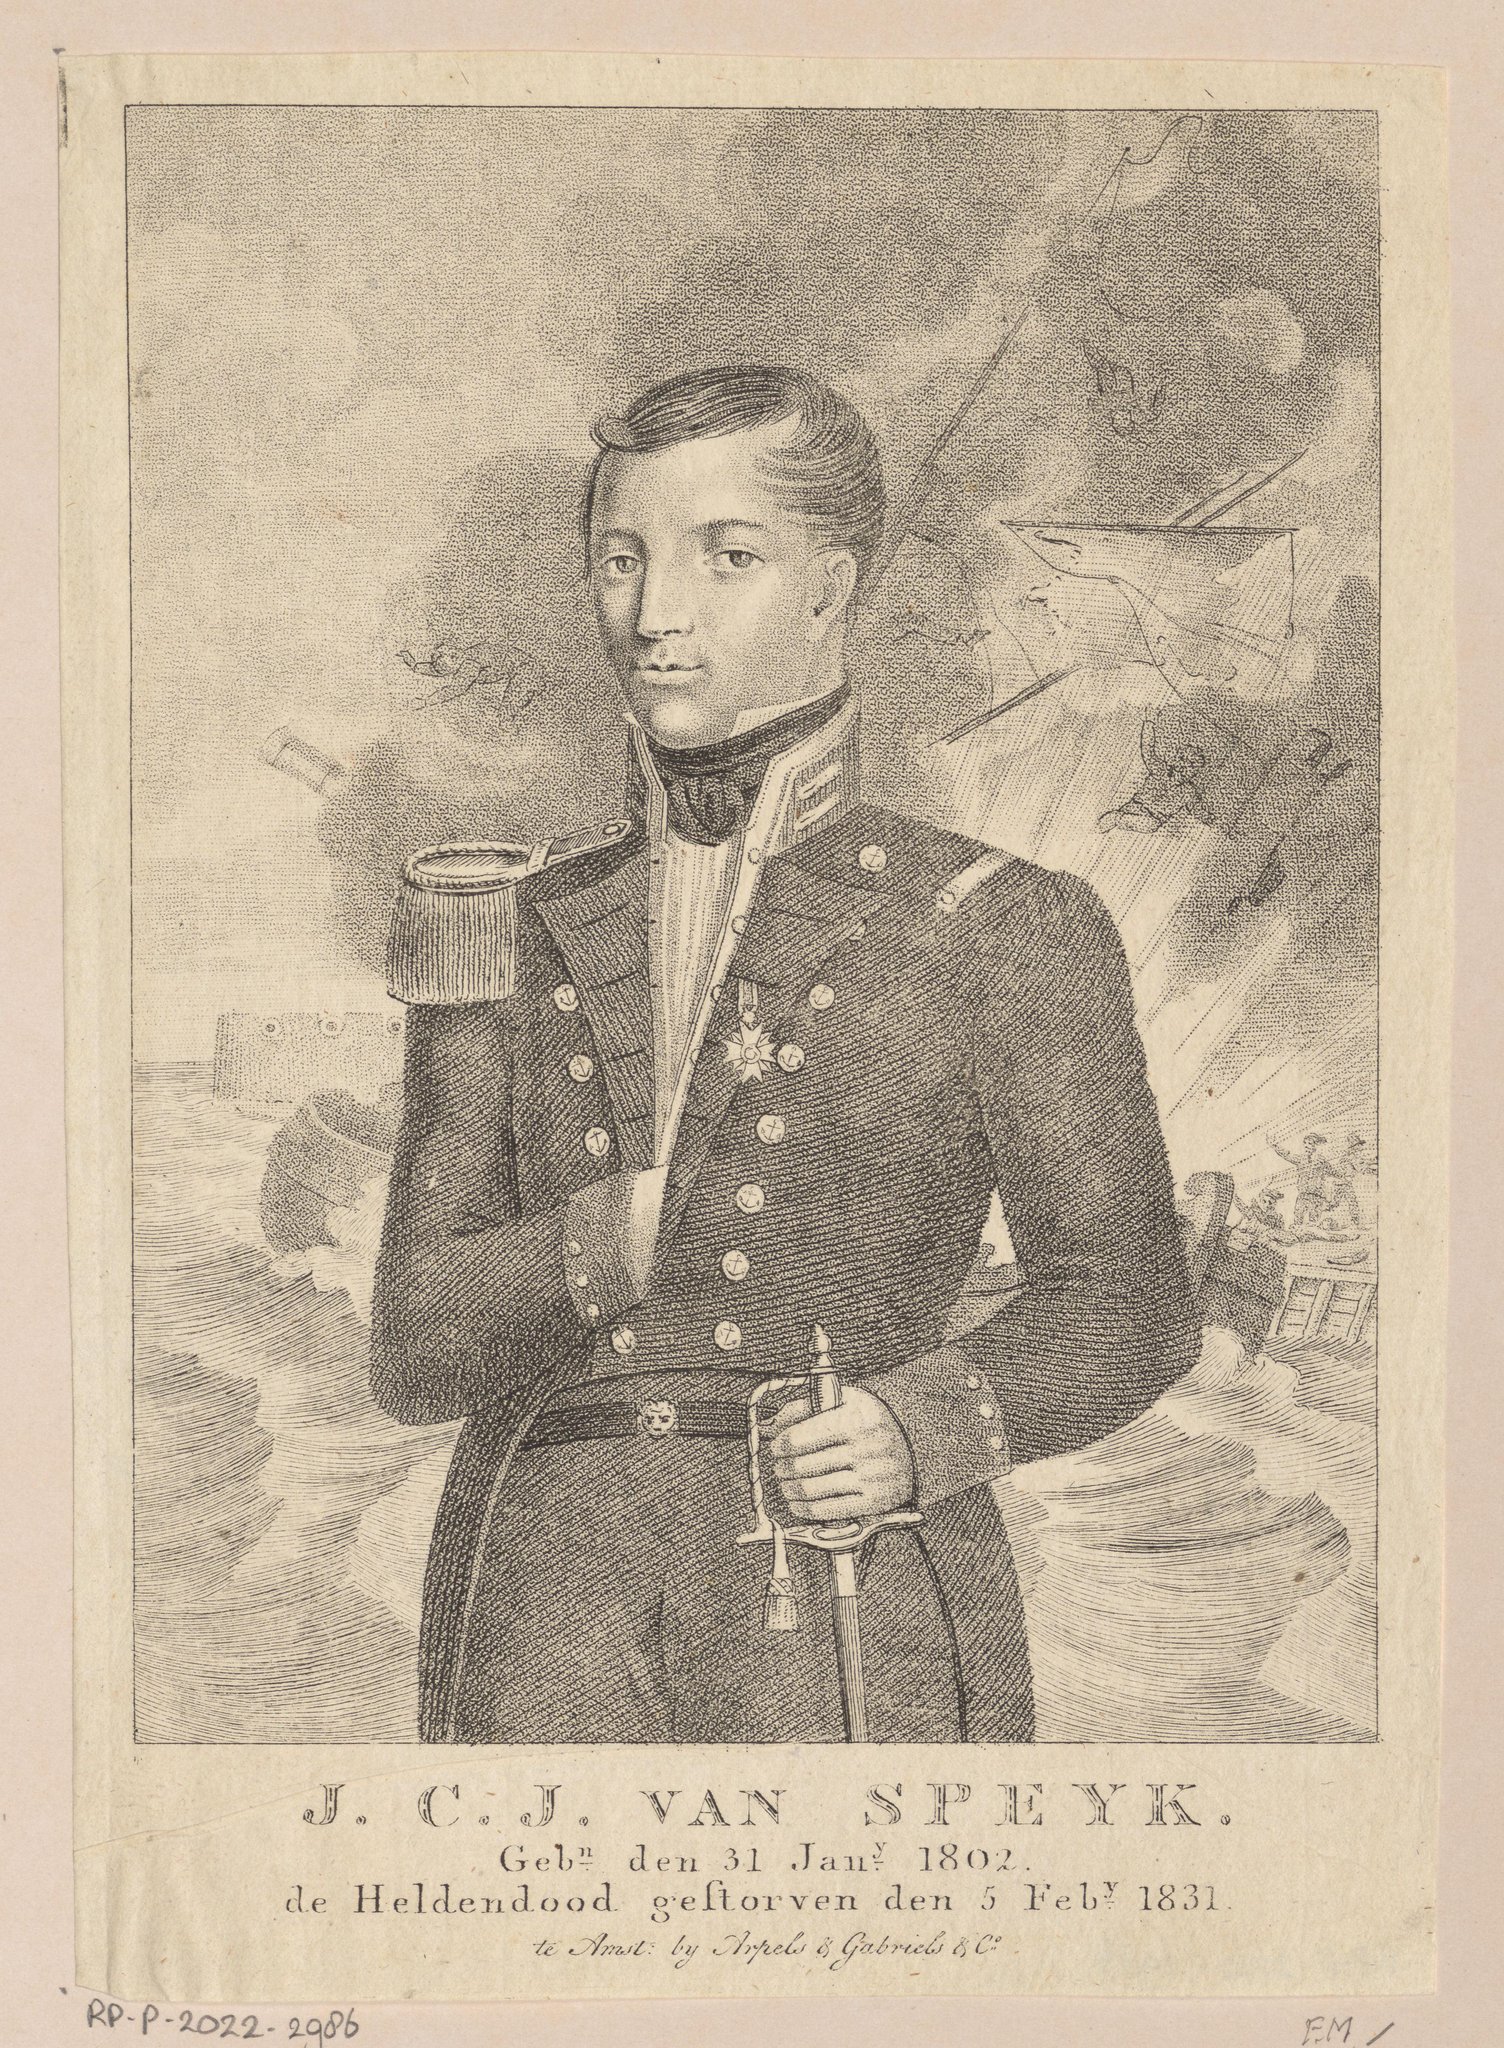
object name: print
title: Portret van Jan van Speyk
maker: Anonymous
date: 1831-1832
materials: paper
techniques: etching, roulette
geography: amsterdam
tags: amsterdam, jan van speyk, historical persons, commander-in-chief, admiral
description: Met tweeregelig onderschrift in het Nederlands.